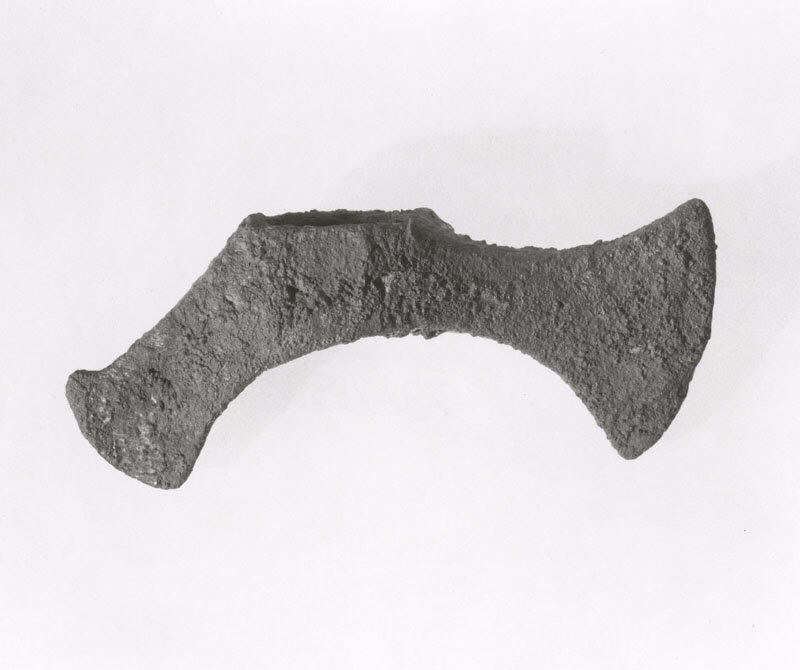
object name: axe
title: Axe with shaft hole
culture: bactria-margiana archaeological complex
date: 2333-1668 BCE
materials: copper alloy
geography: bactria-margiana